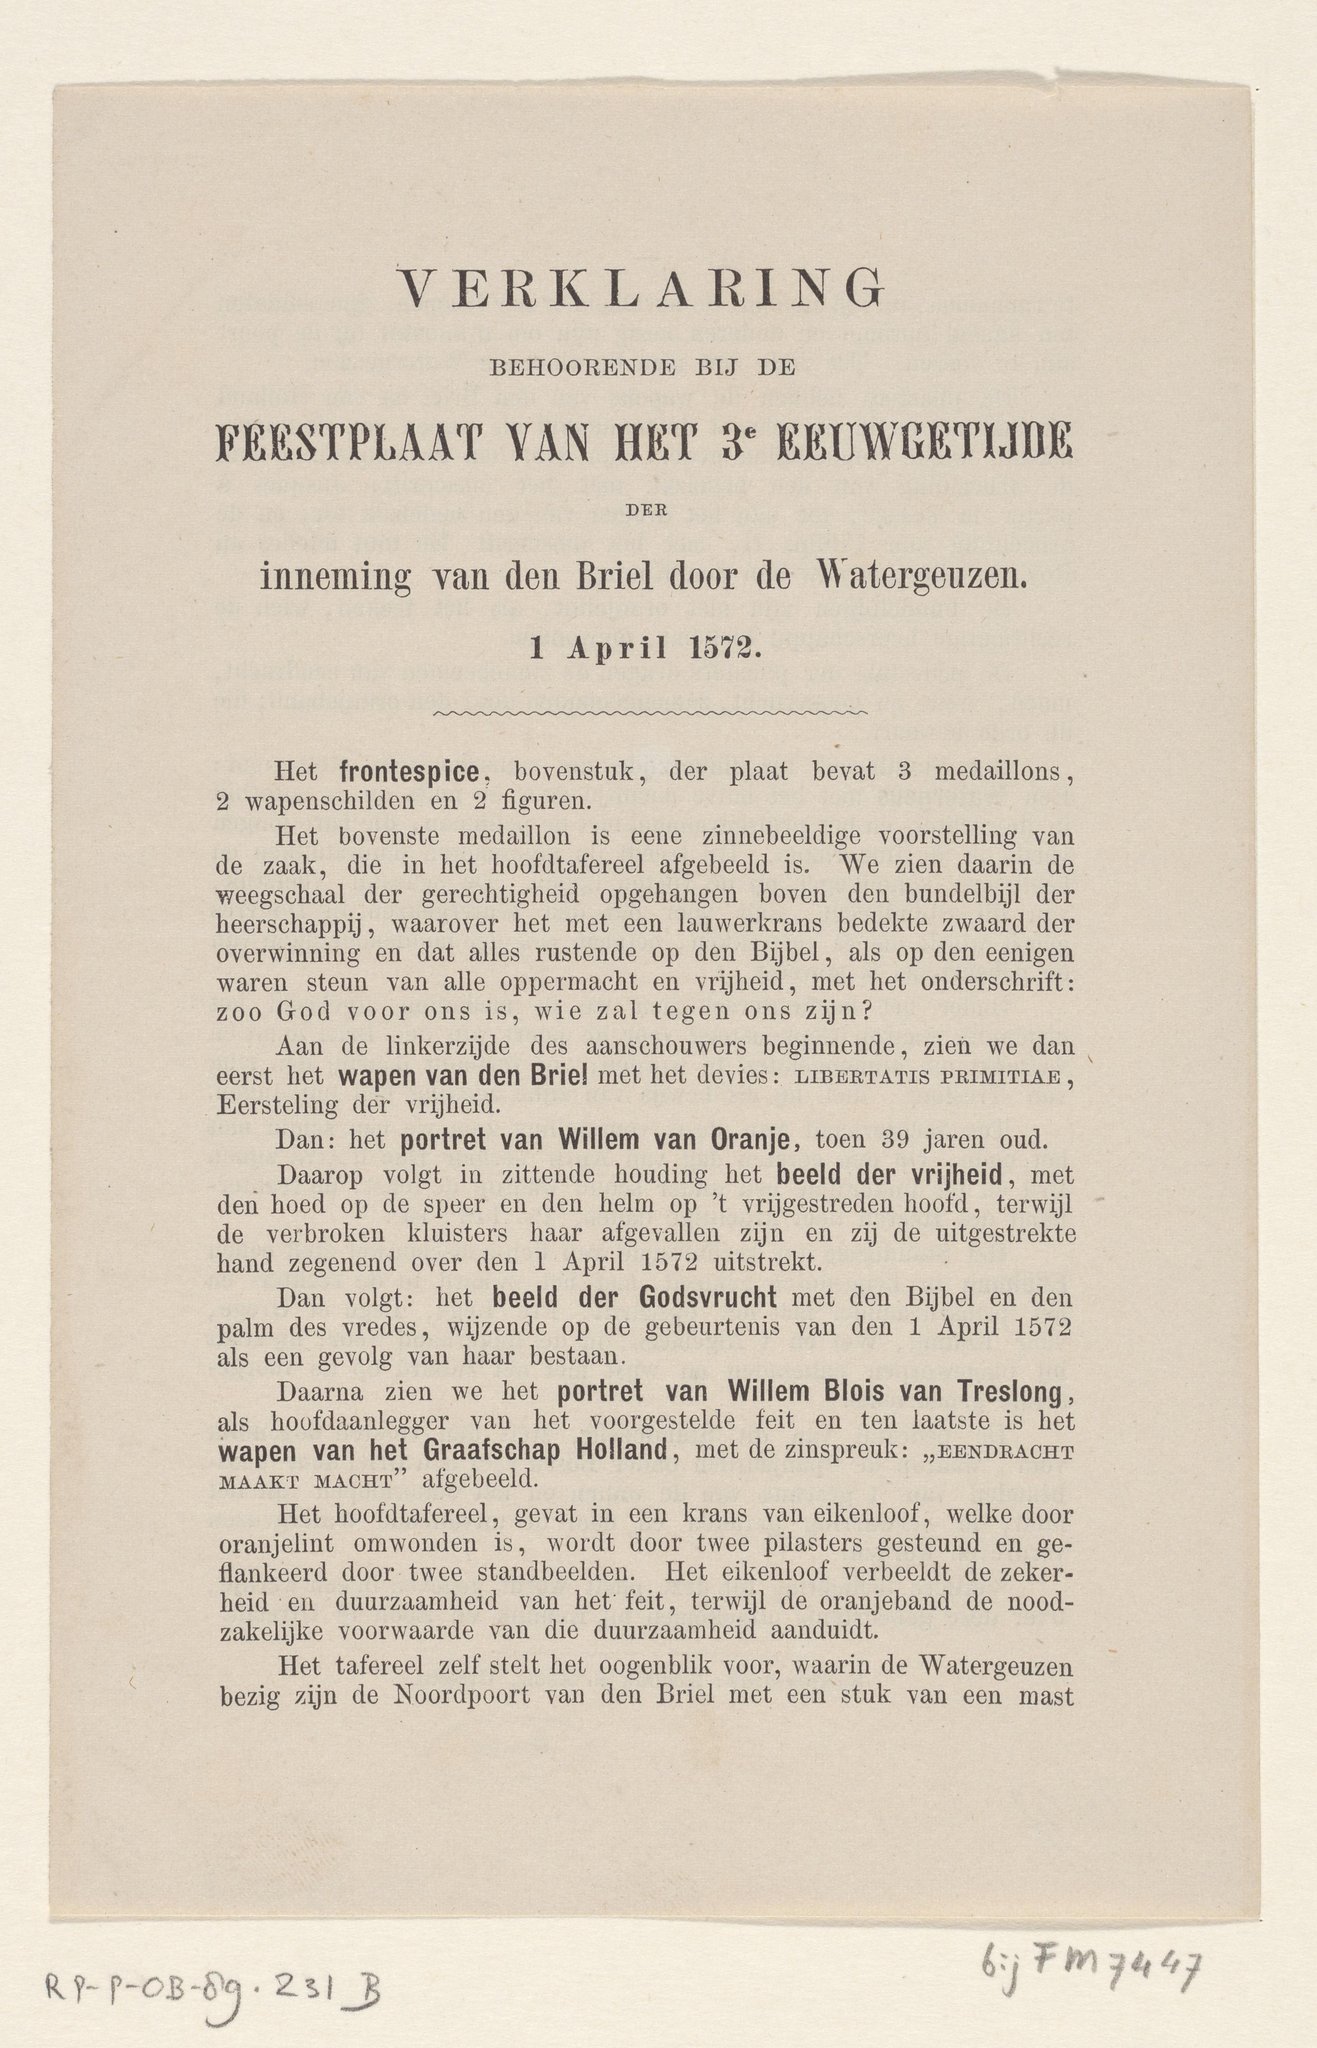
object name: text sheet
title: Verklaring behoorende bij de Feestplaat van het 3e Eeuwgetijde der inneming van den Briel door de Watergeuzen. 1 April 1572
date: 1872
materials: paper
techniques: letterpress printing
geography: utrecht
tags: brielle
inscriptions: collector's mark: Lugt 2228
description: Verklaring behorend bij de gedenkplaat van de inneming van Den Briel op 1 april 1572 bij de viering van 300 jaar Nederlandse vrijheid 1572-1872. Tekstblad bedrukt met tekst op beide zijden.